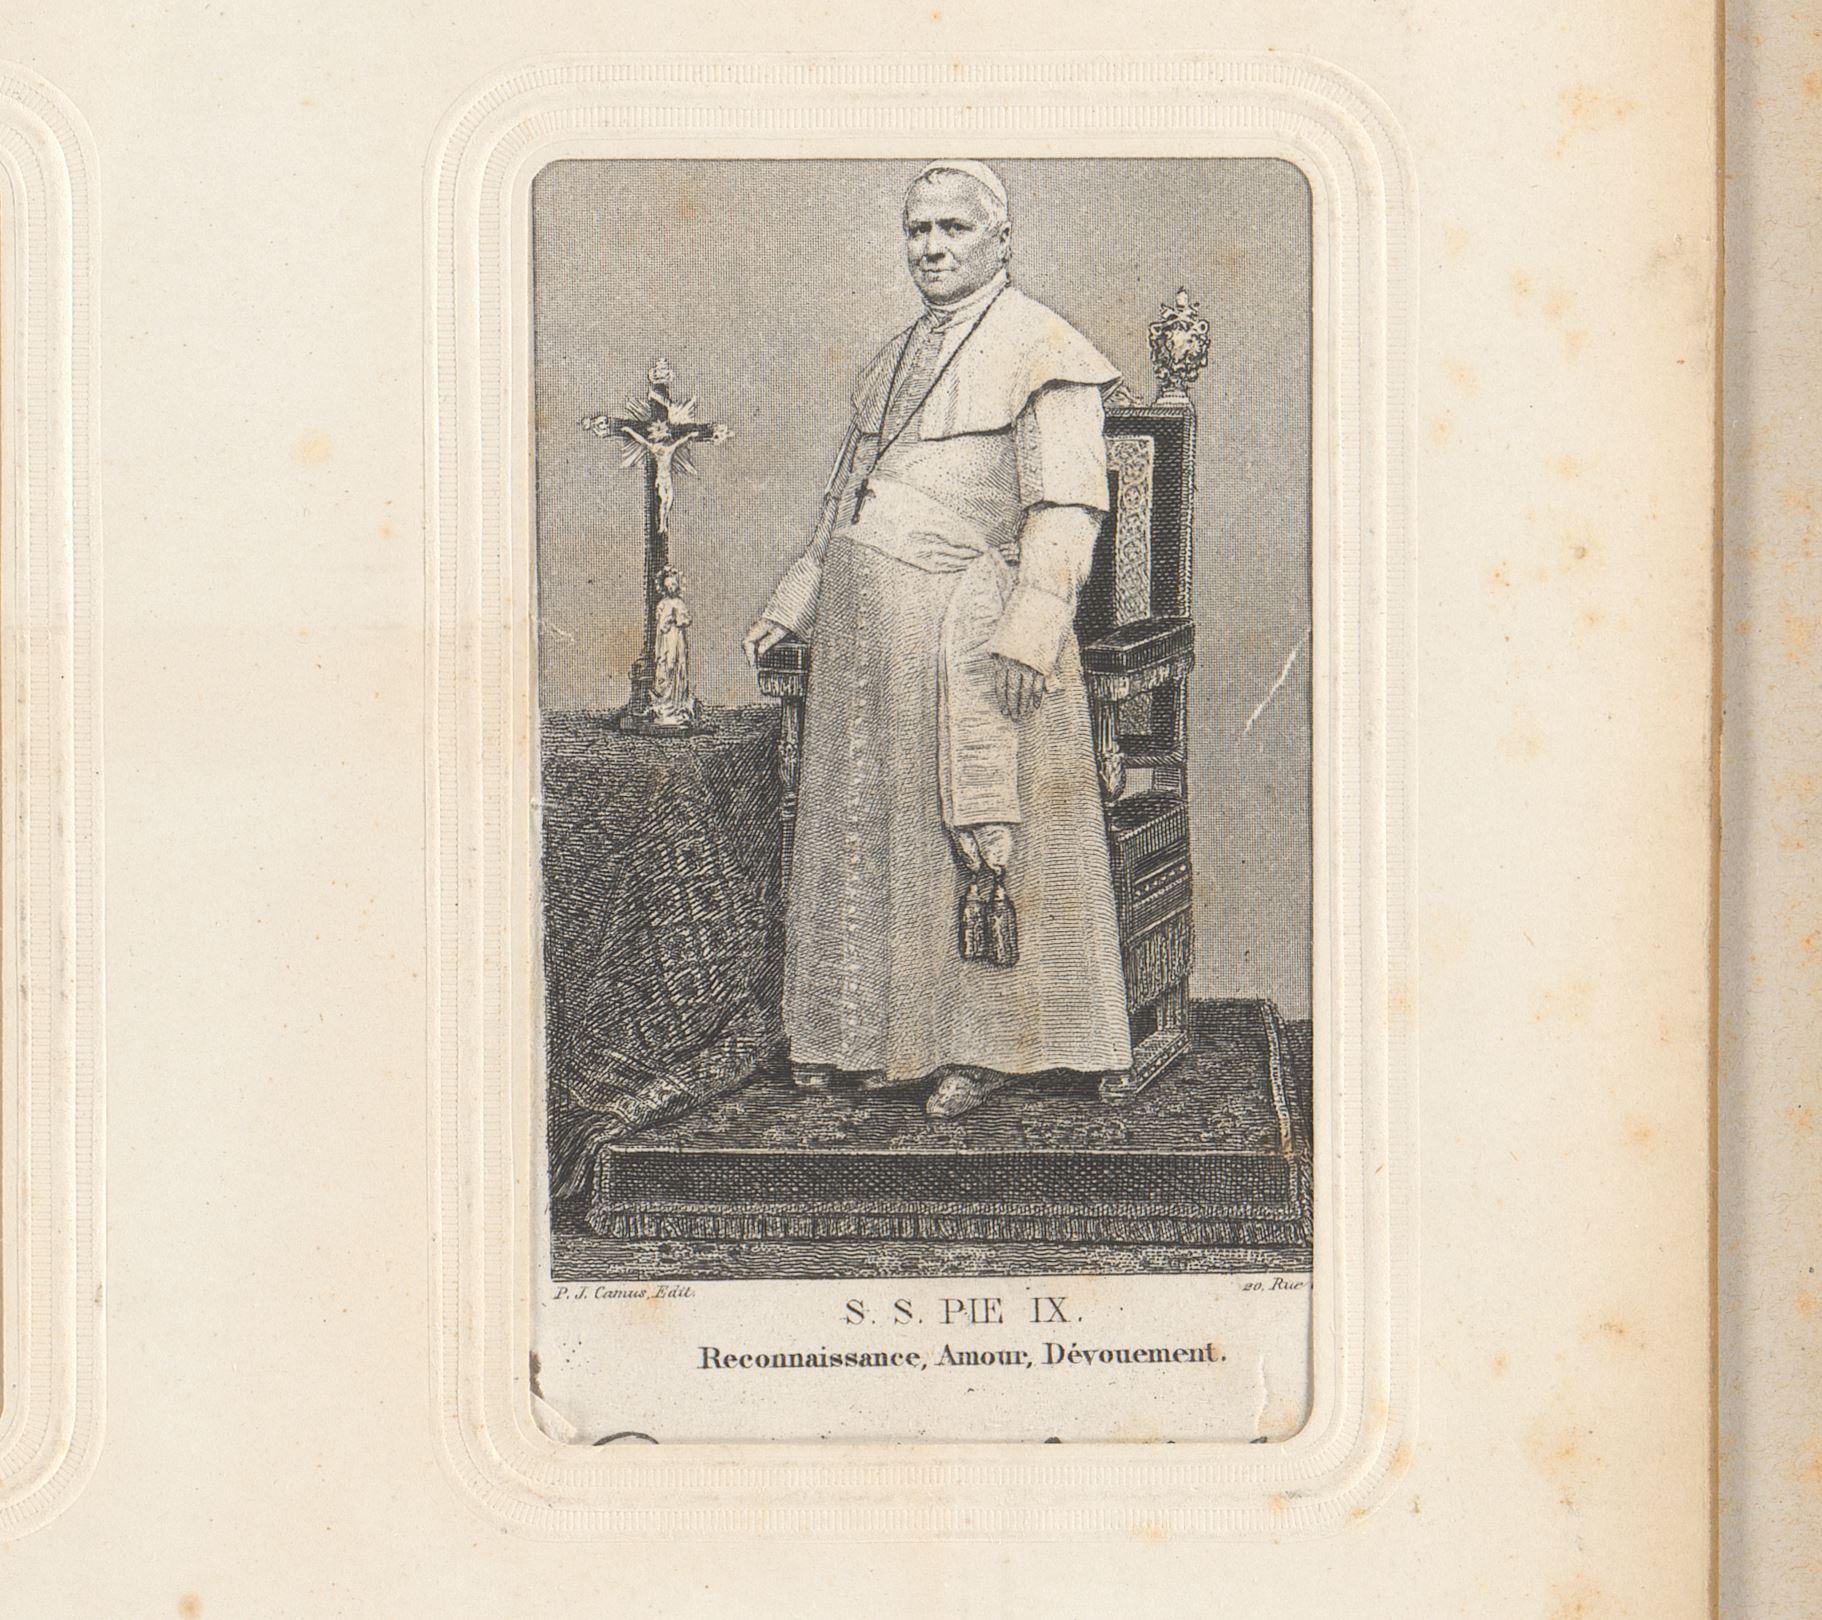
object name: album leaf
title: Portret van Paus Pius IX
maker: Anonymous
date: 1846-1900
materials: paper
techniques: engraving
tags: historical persons, pope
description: Deze prent maakt deel uit van een album.